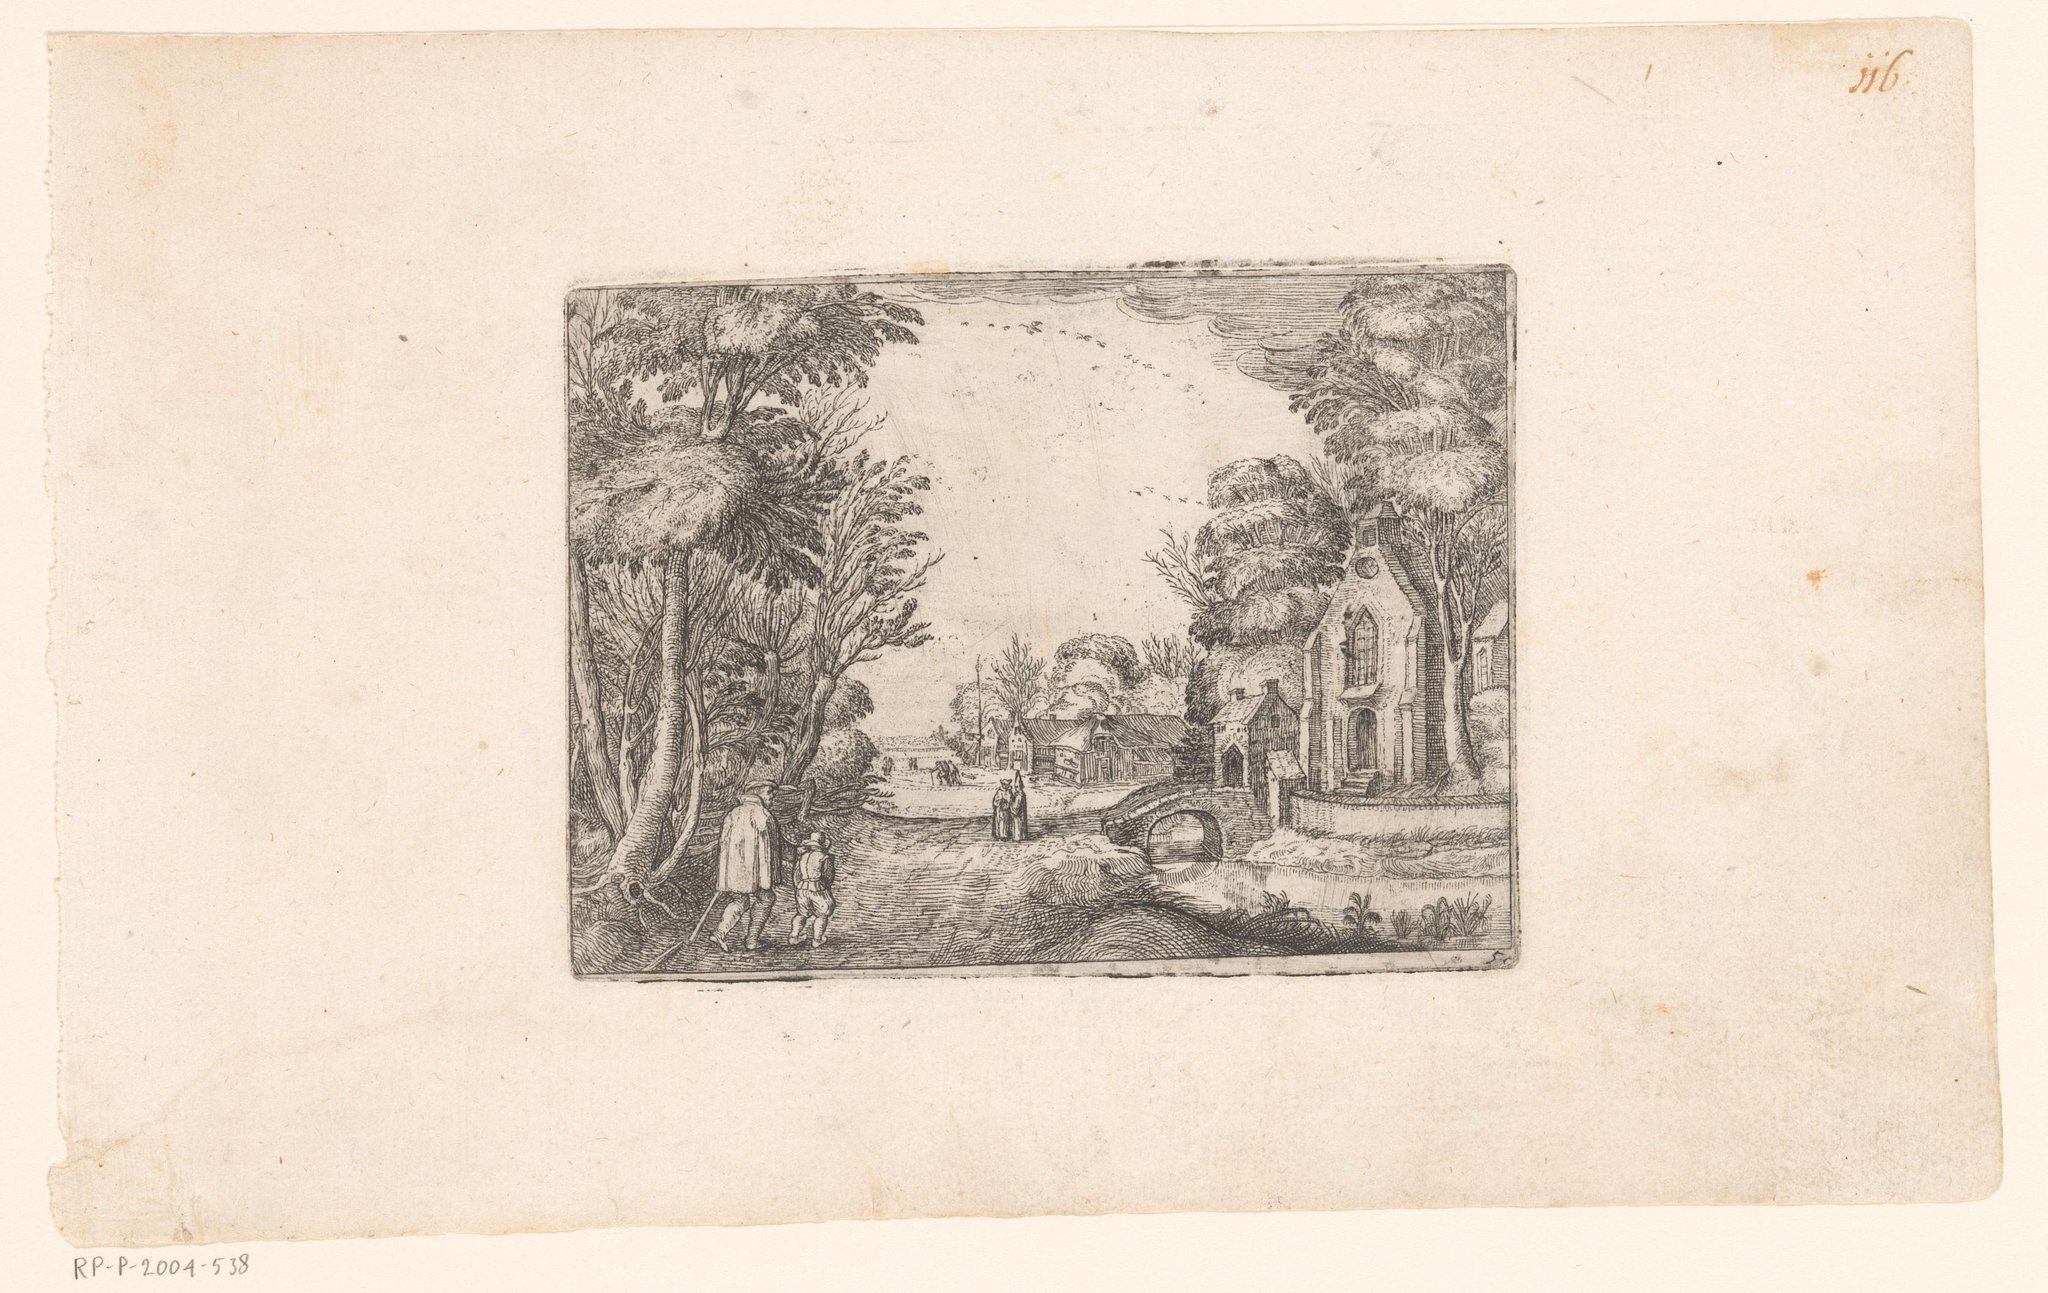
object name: print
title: Dorpsgezicht met links een bospad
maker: jacob van der heyden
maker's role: draughtsman, print maker, publisher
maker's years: 1573-1645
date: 1583-1645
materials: paper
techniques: etching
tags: prospect of village, silhouette of village, church (exterior), road, path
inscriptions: collector's mark: Lugt 2760, collector's mark: Lugt 2228